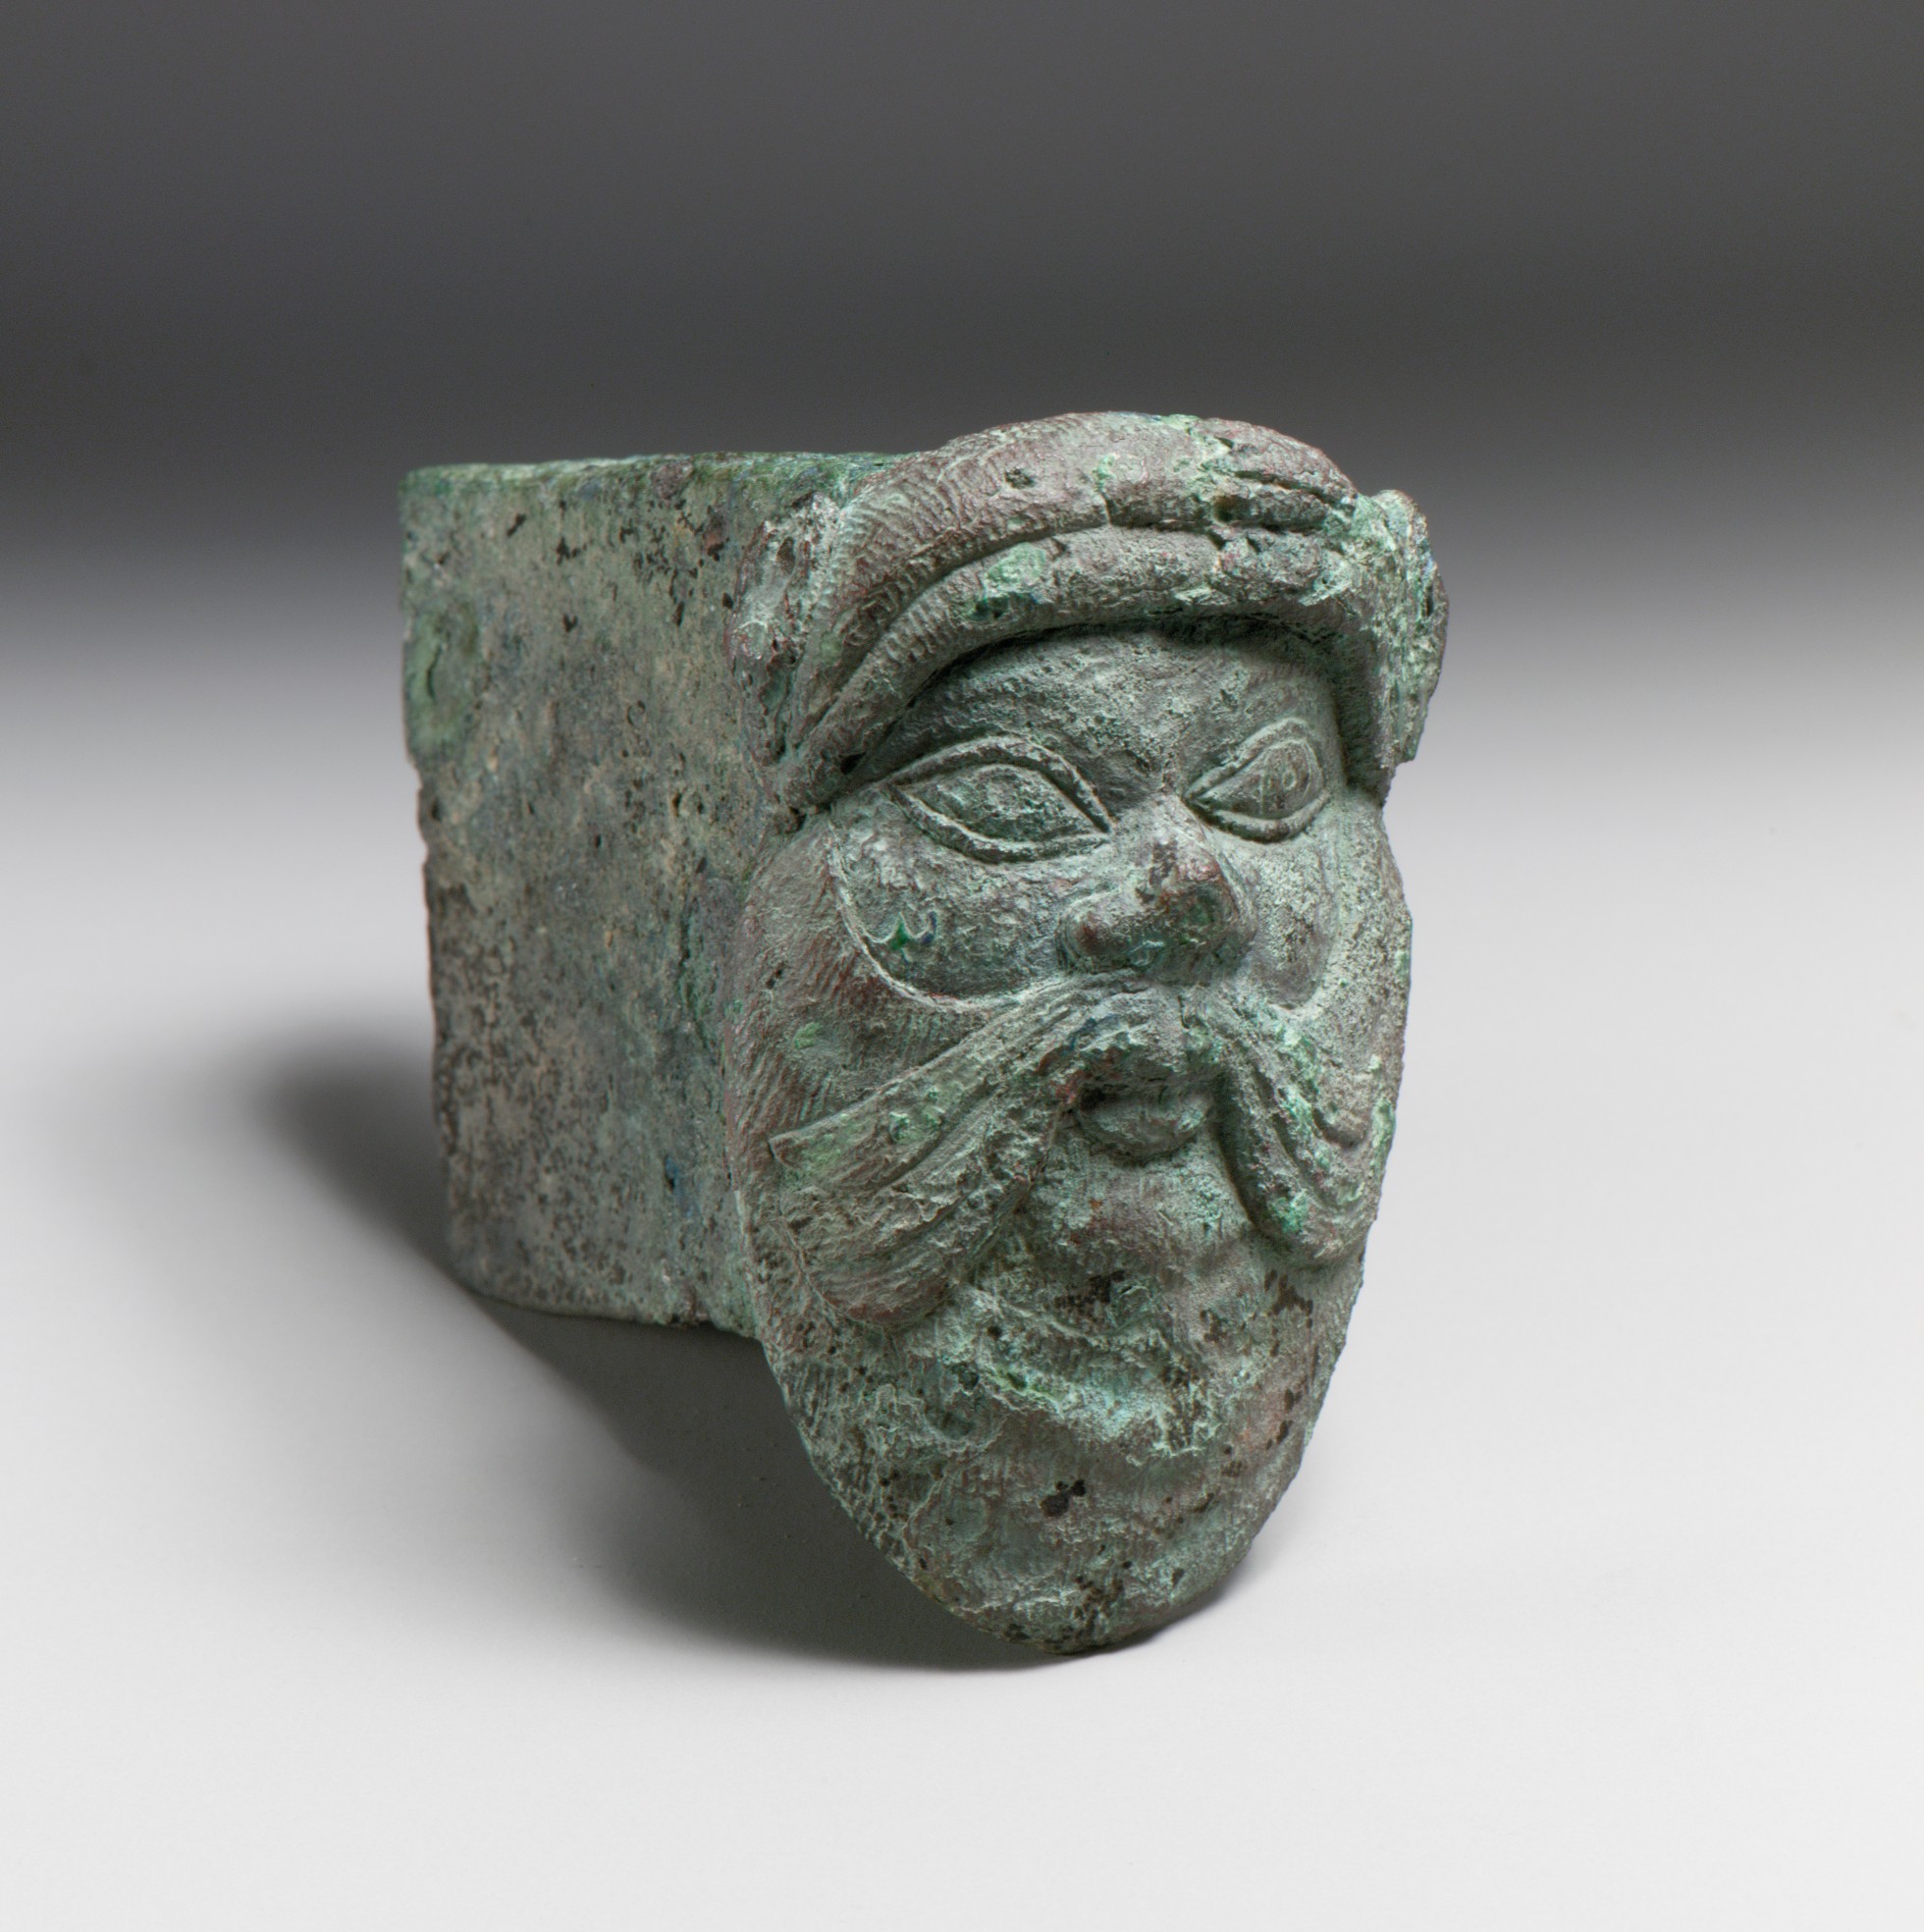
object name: chariot fragment, socket with satyr mask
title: Fragment of a cart or chariot, socket with satyr mask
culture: etruscan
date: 500-480 BCE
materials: bronze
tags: masks,satyrs